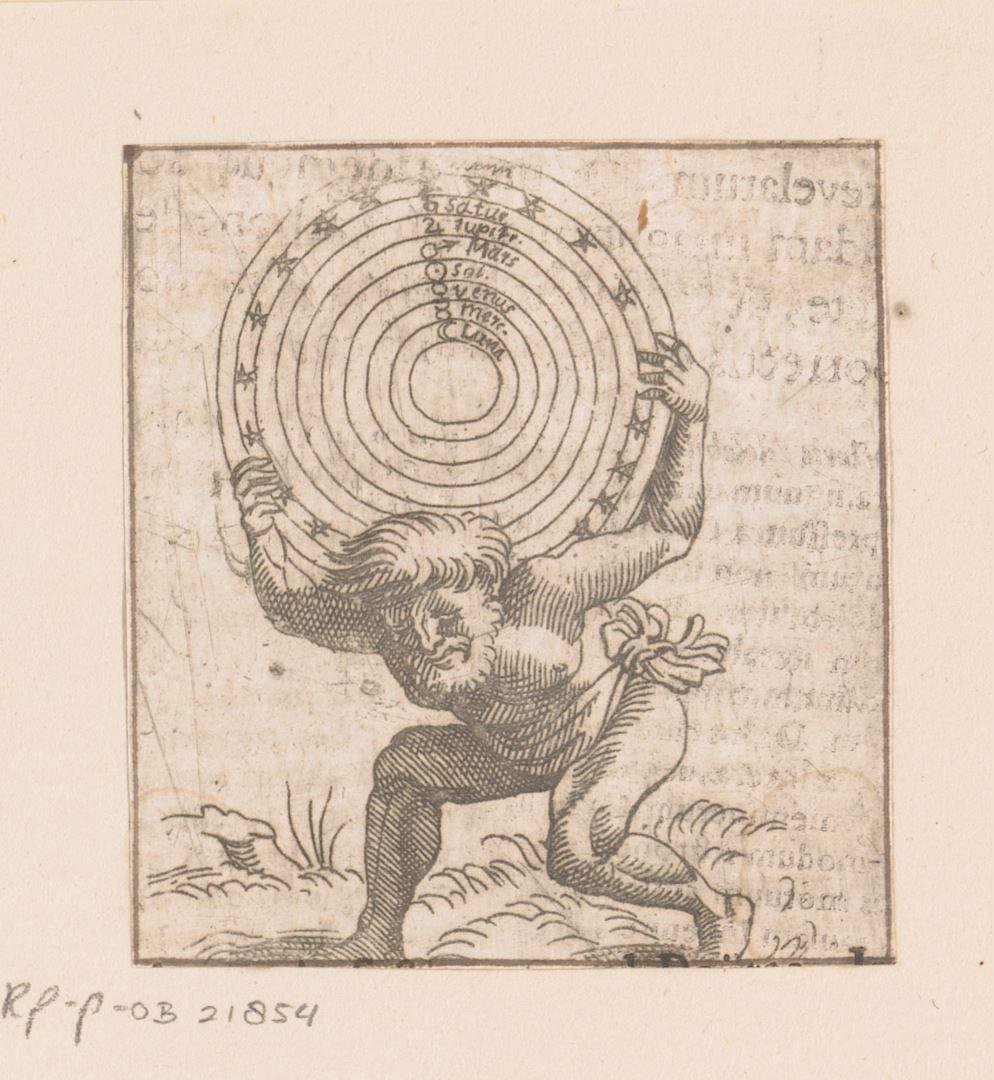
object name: print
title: Atlas draagt de hemelgewelven op zijn schouders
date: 1516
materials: paper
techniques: etching, letterpress printing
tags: rotterdam, desiderius erasmus, (story of) atlas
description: Prent afkomstig uit: Erasmus, Desiderius. Morias enkomion (...). Bazel: Johann Rudolf Genath, 1676. De prenten hierin zijn naar tekeningen die Hans en Ambrosius Holbein maakten voor de theoloog Oswald Myconius in diens uitgave van de Moriae encomium (Lof der Zotheid) van 1516.